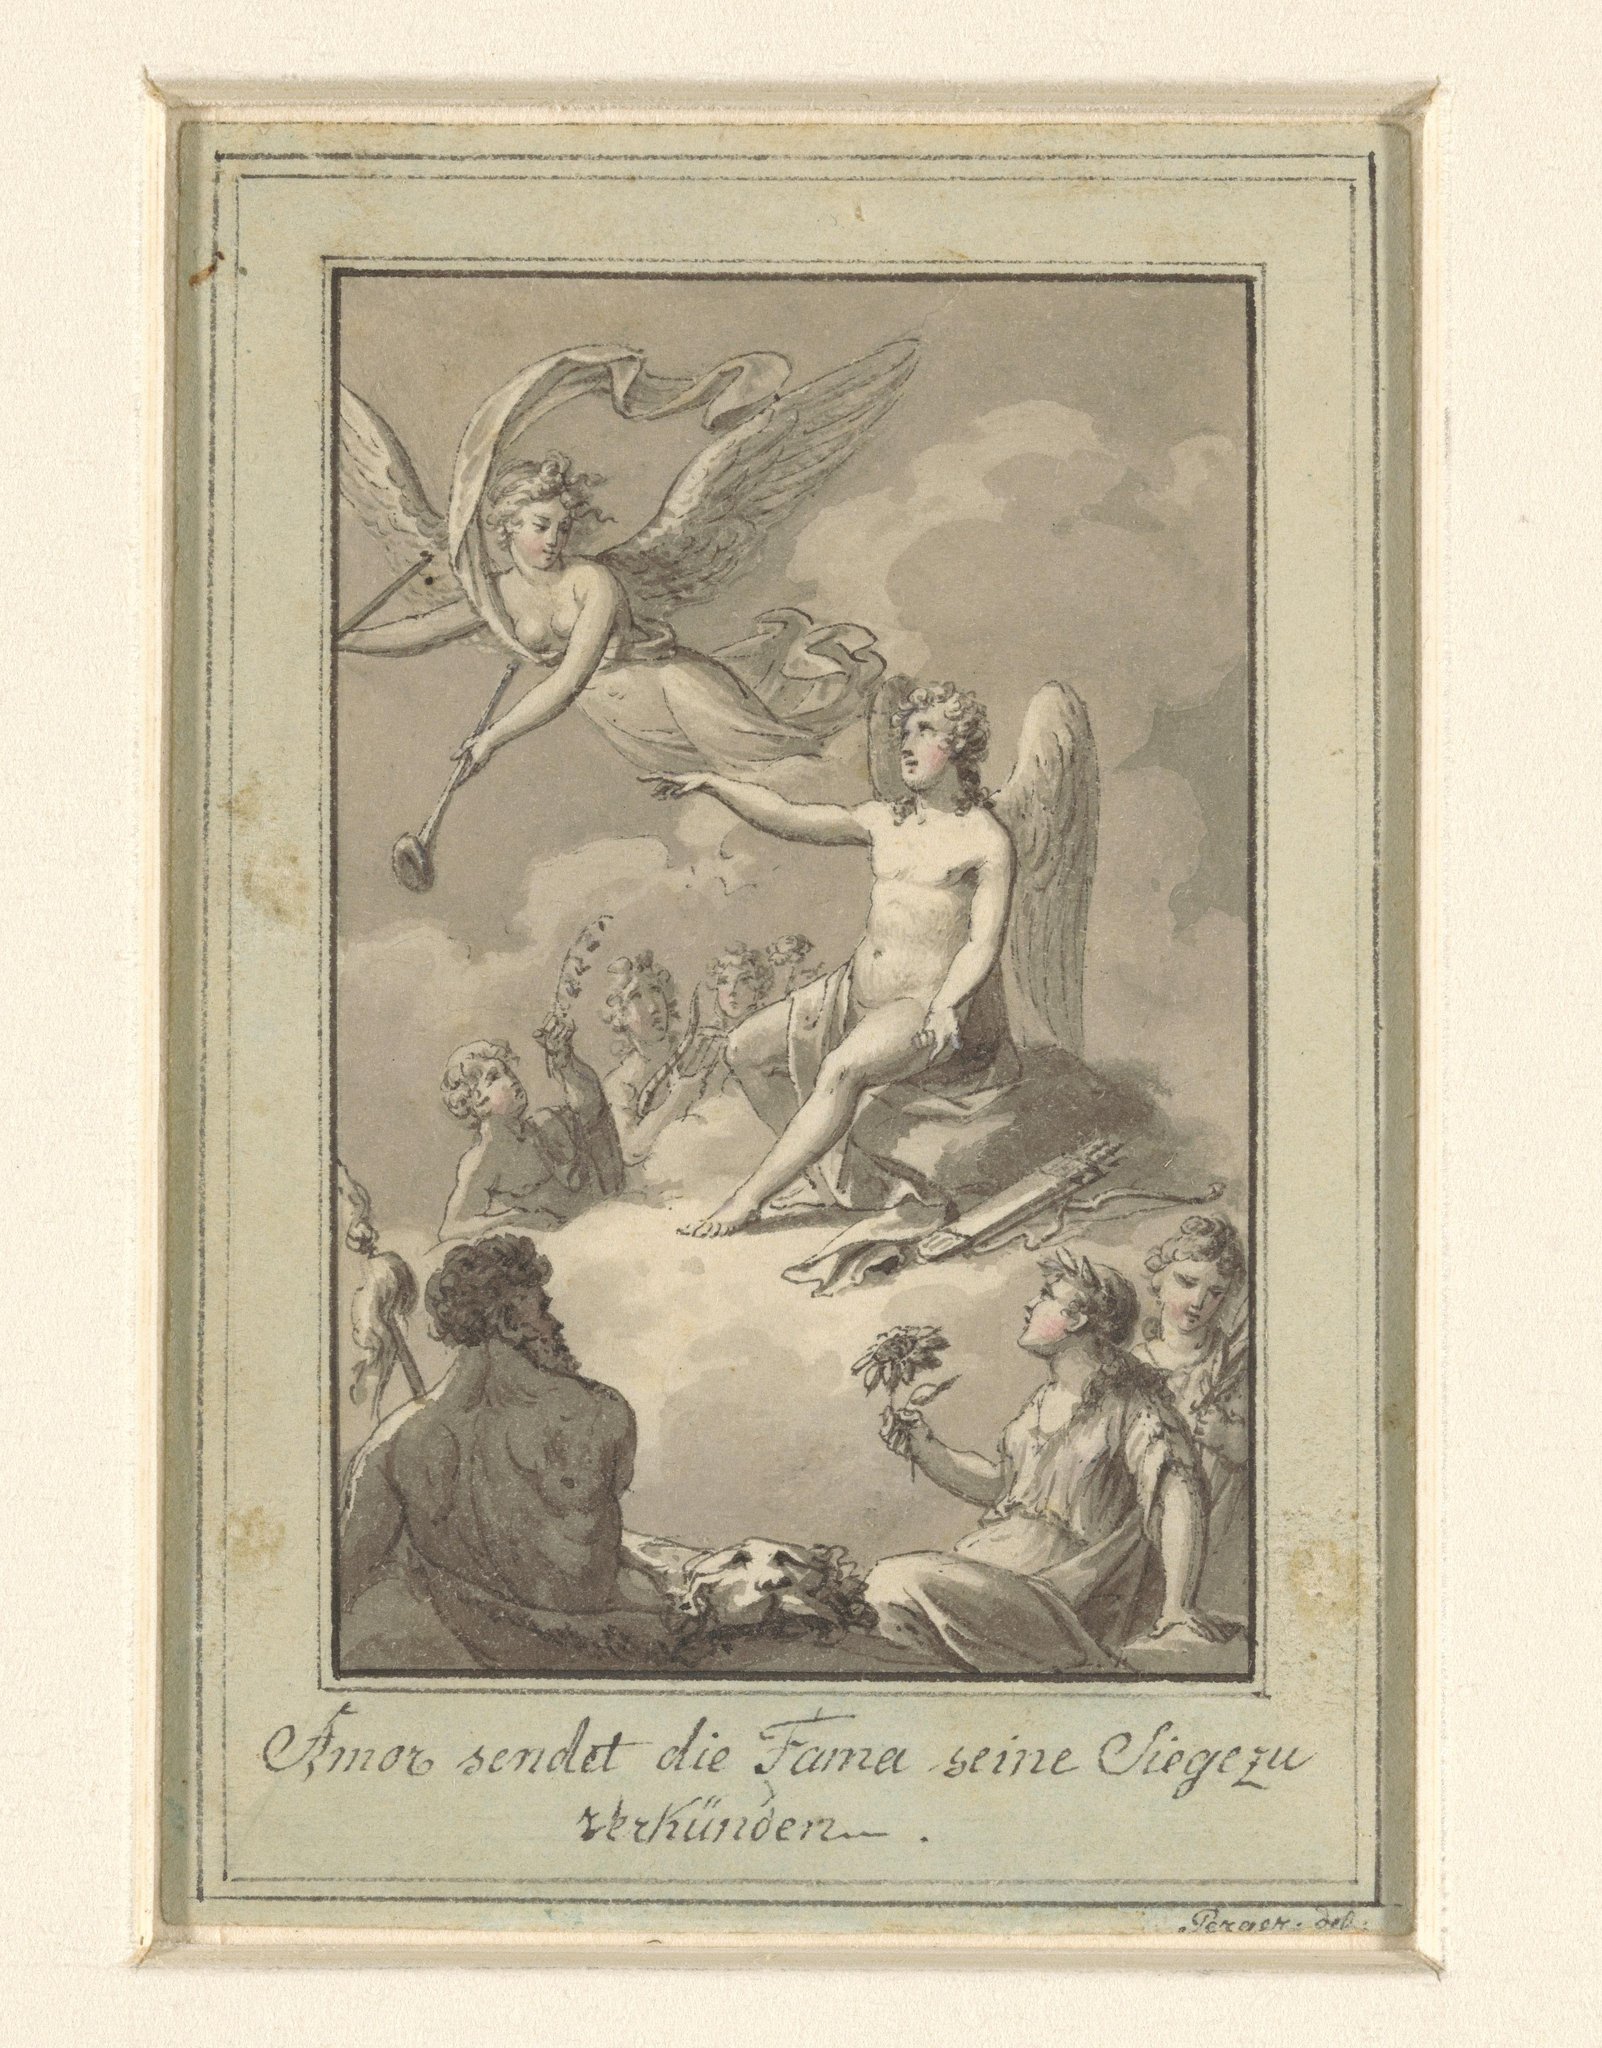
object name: drawing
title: Amor stuurt Fama weg om zijn verovering te verkondigen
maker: sigmund ferdinand ritter von perger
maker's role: draughtsman, painter, print maker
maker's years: 1778-1841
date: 1788-1841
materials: ink, paper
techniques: brush, pen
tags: (story of) cupid, amor (eros), fame; 'fama', 'fama buona', 'fama chiara' (ripa)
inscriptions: inscription: ‘Amor sendet die Fama seine Siege zu verkünden’